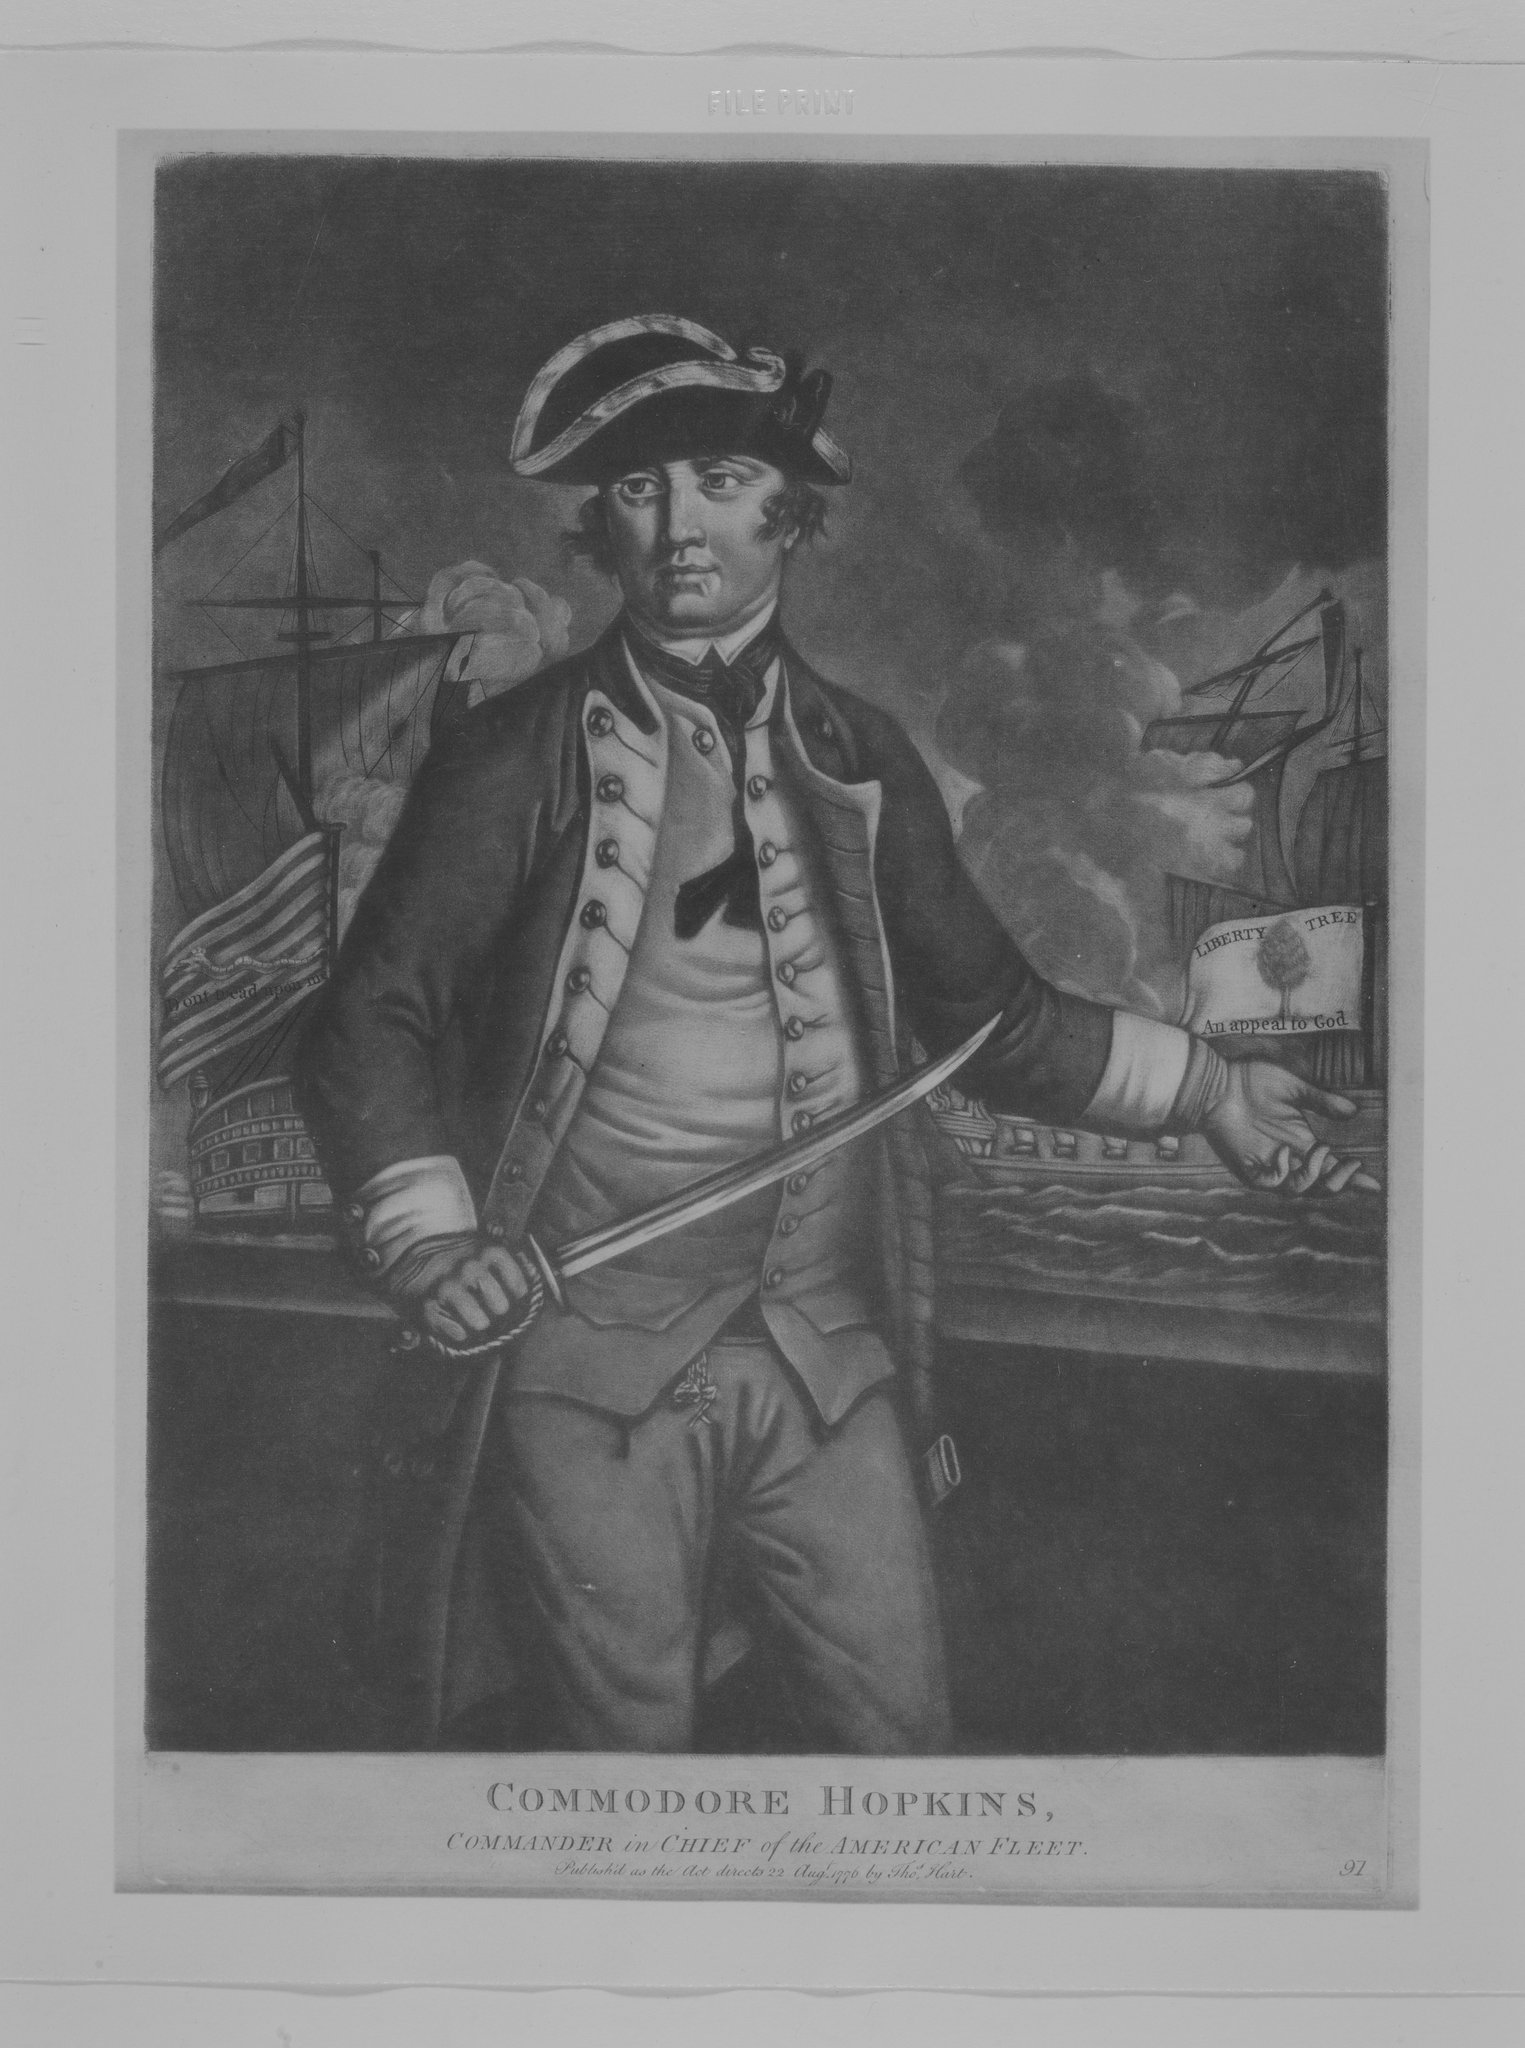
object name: print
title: Commodore Hopkins, Commander in Chief of the American Fleet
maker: anonymous, 18th century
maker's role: engraver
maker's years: 1700-1800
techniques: mezzotint